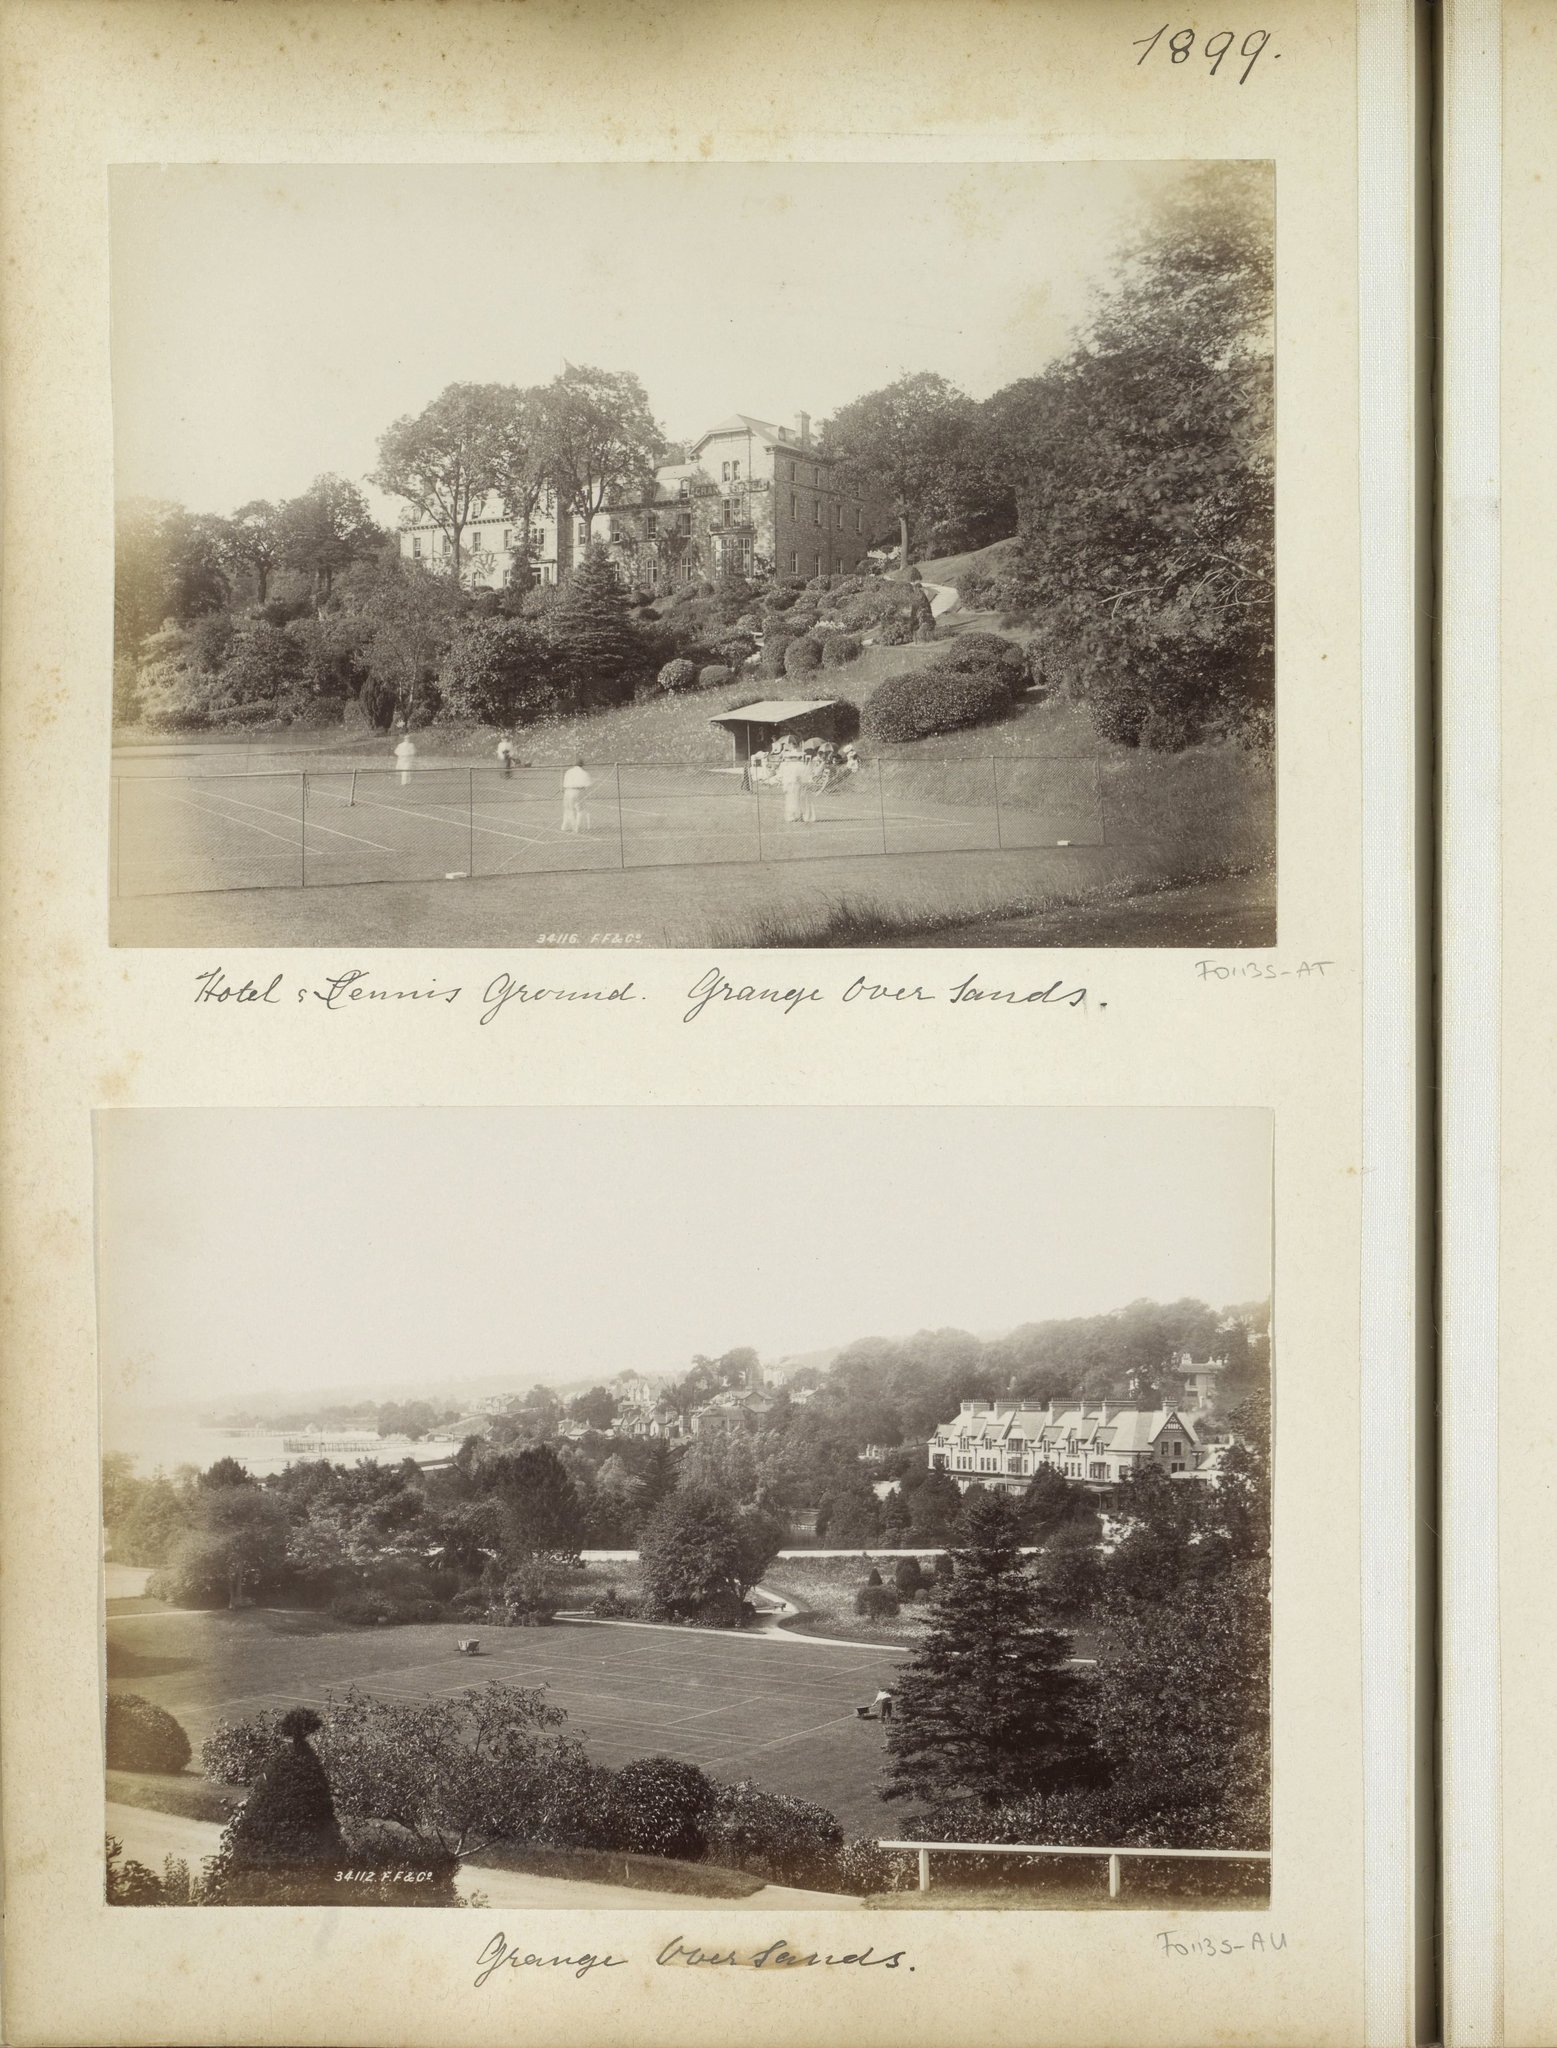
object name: album leaf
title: Gezicht op tennisbanen en een groundsman in Grange-over-Sands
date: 1899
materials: paper, photographic support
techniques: albumen print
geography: grange-over-sands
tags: prospect of village, silhouette of village, tennis, lawn-tennis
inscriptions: number: ‘34112’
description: Onderdeel van Reisalbum met foto's van bezienswaardigheden in Engeland en Frankrijk.